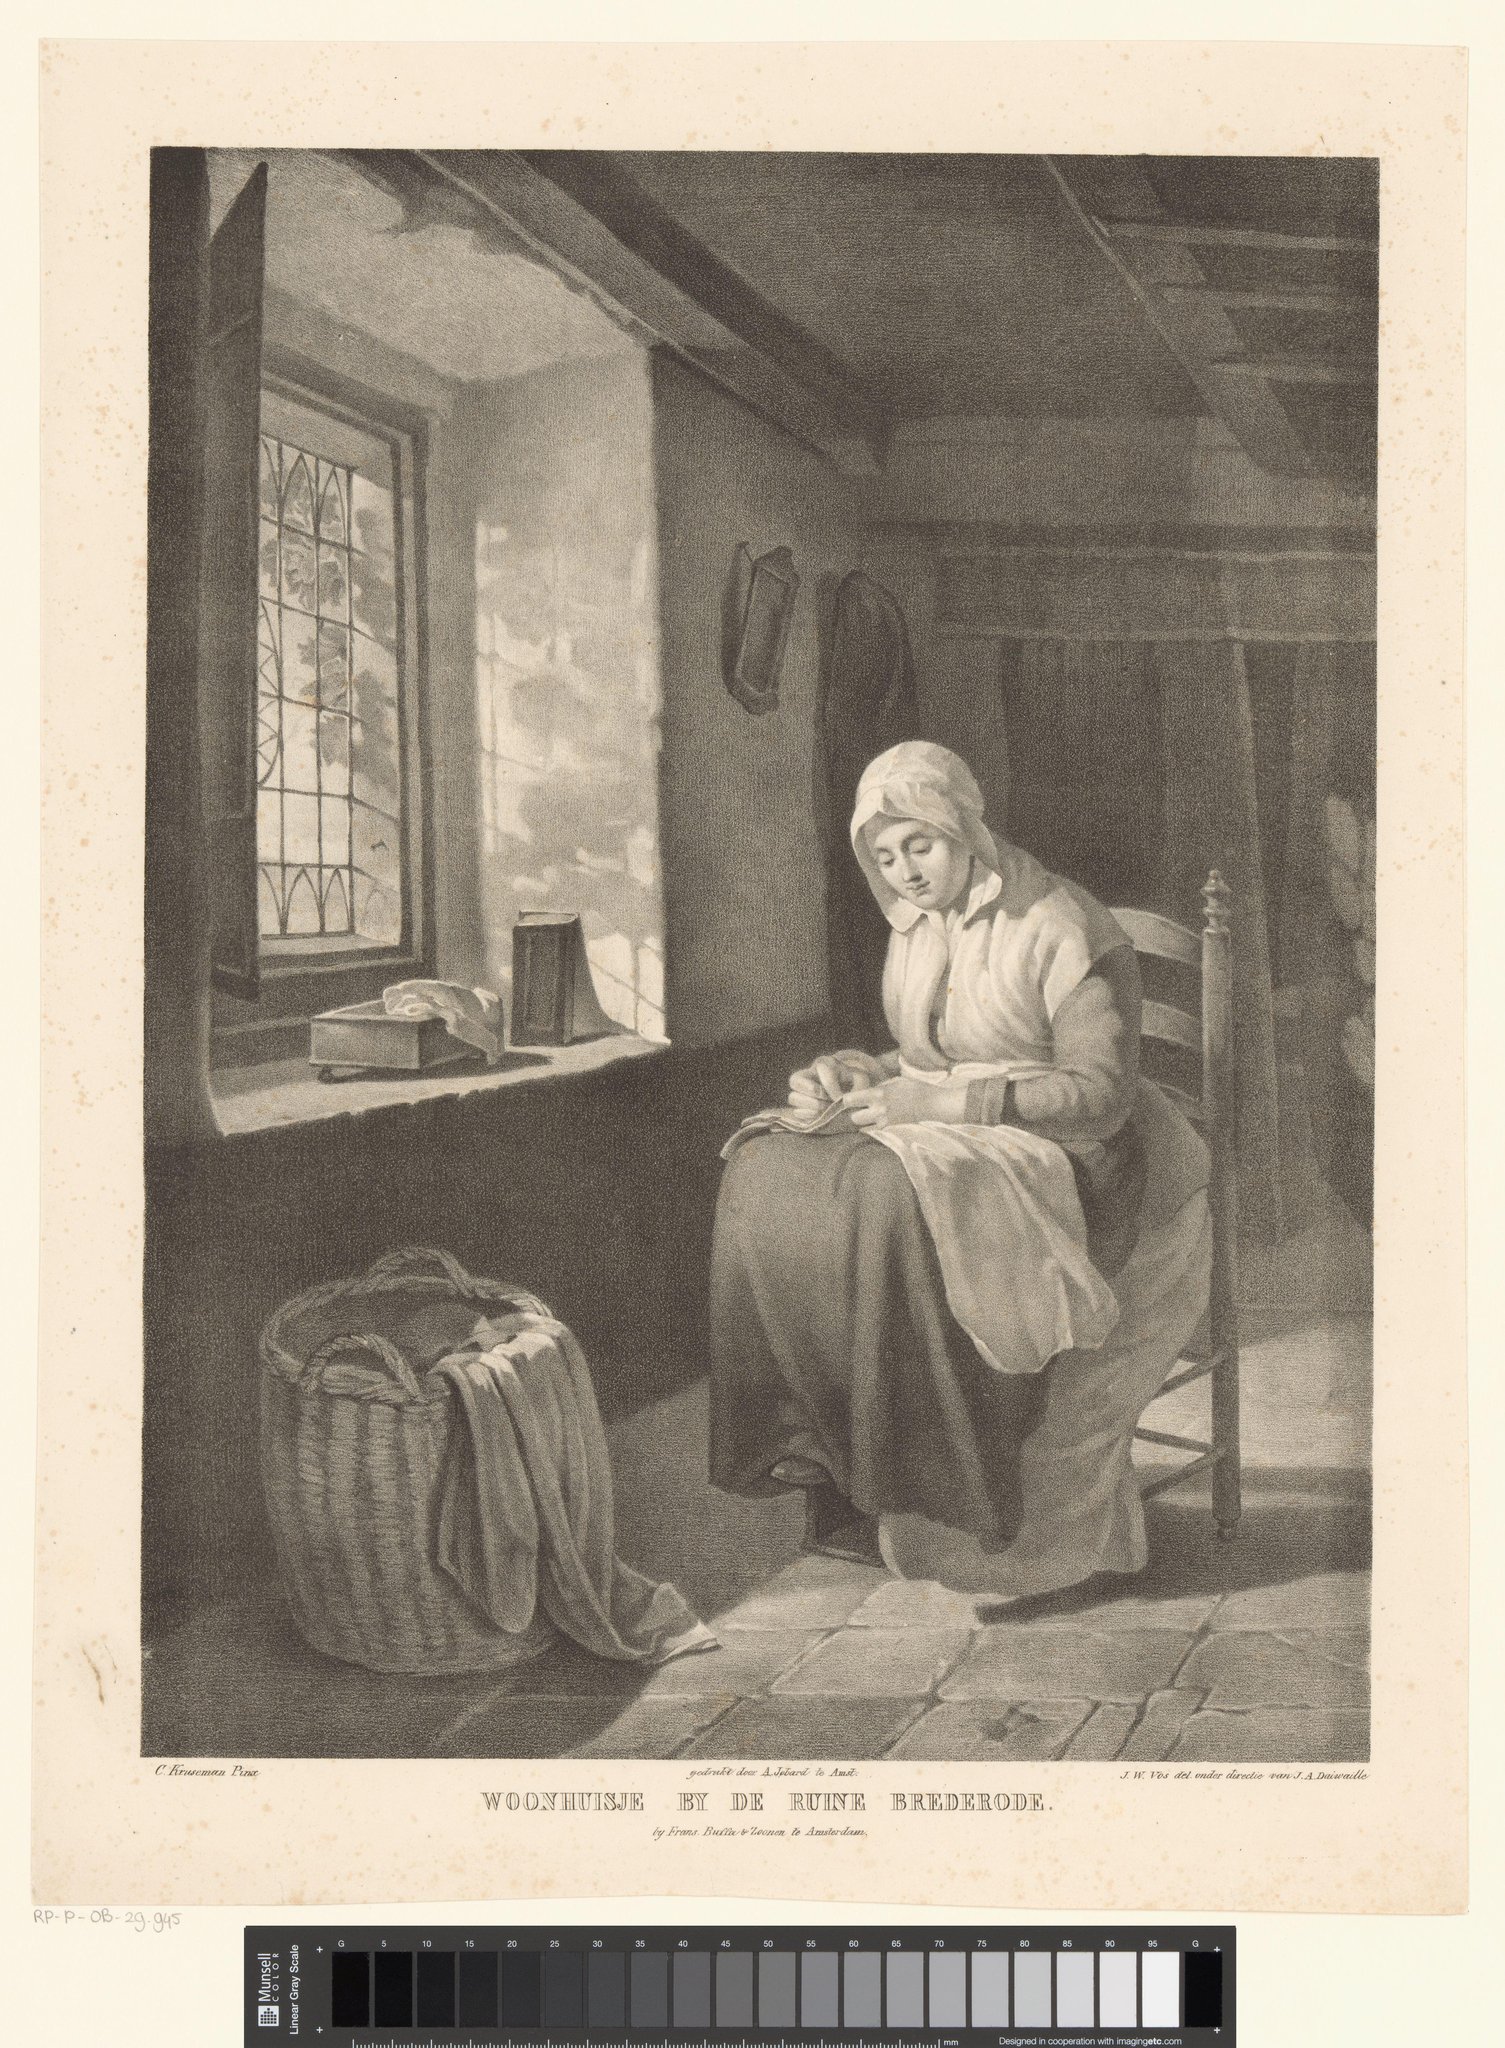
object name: print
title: Woonhuisje bij de ruine Brederode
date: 1827-1828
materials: paper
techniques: lithograph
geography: amsterdam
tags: care and laundering of clothes; home sewing, sitting figure - aa - female human figure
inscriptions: collector's mark: Lugt 2228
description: Een vrouw zit bij een raam met handwerk op schoot. Voor haar staat een mand waaruit een doek of kledingstuk hangt.